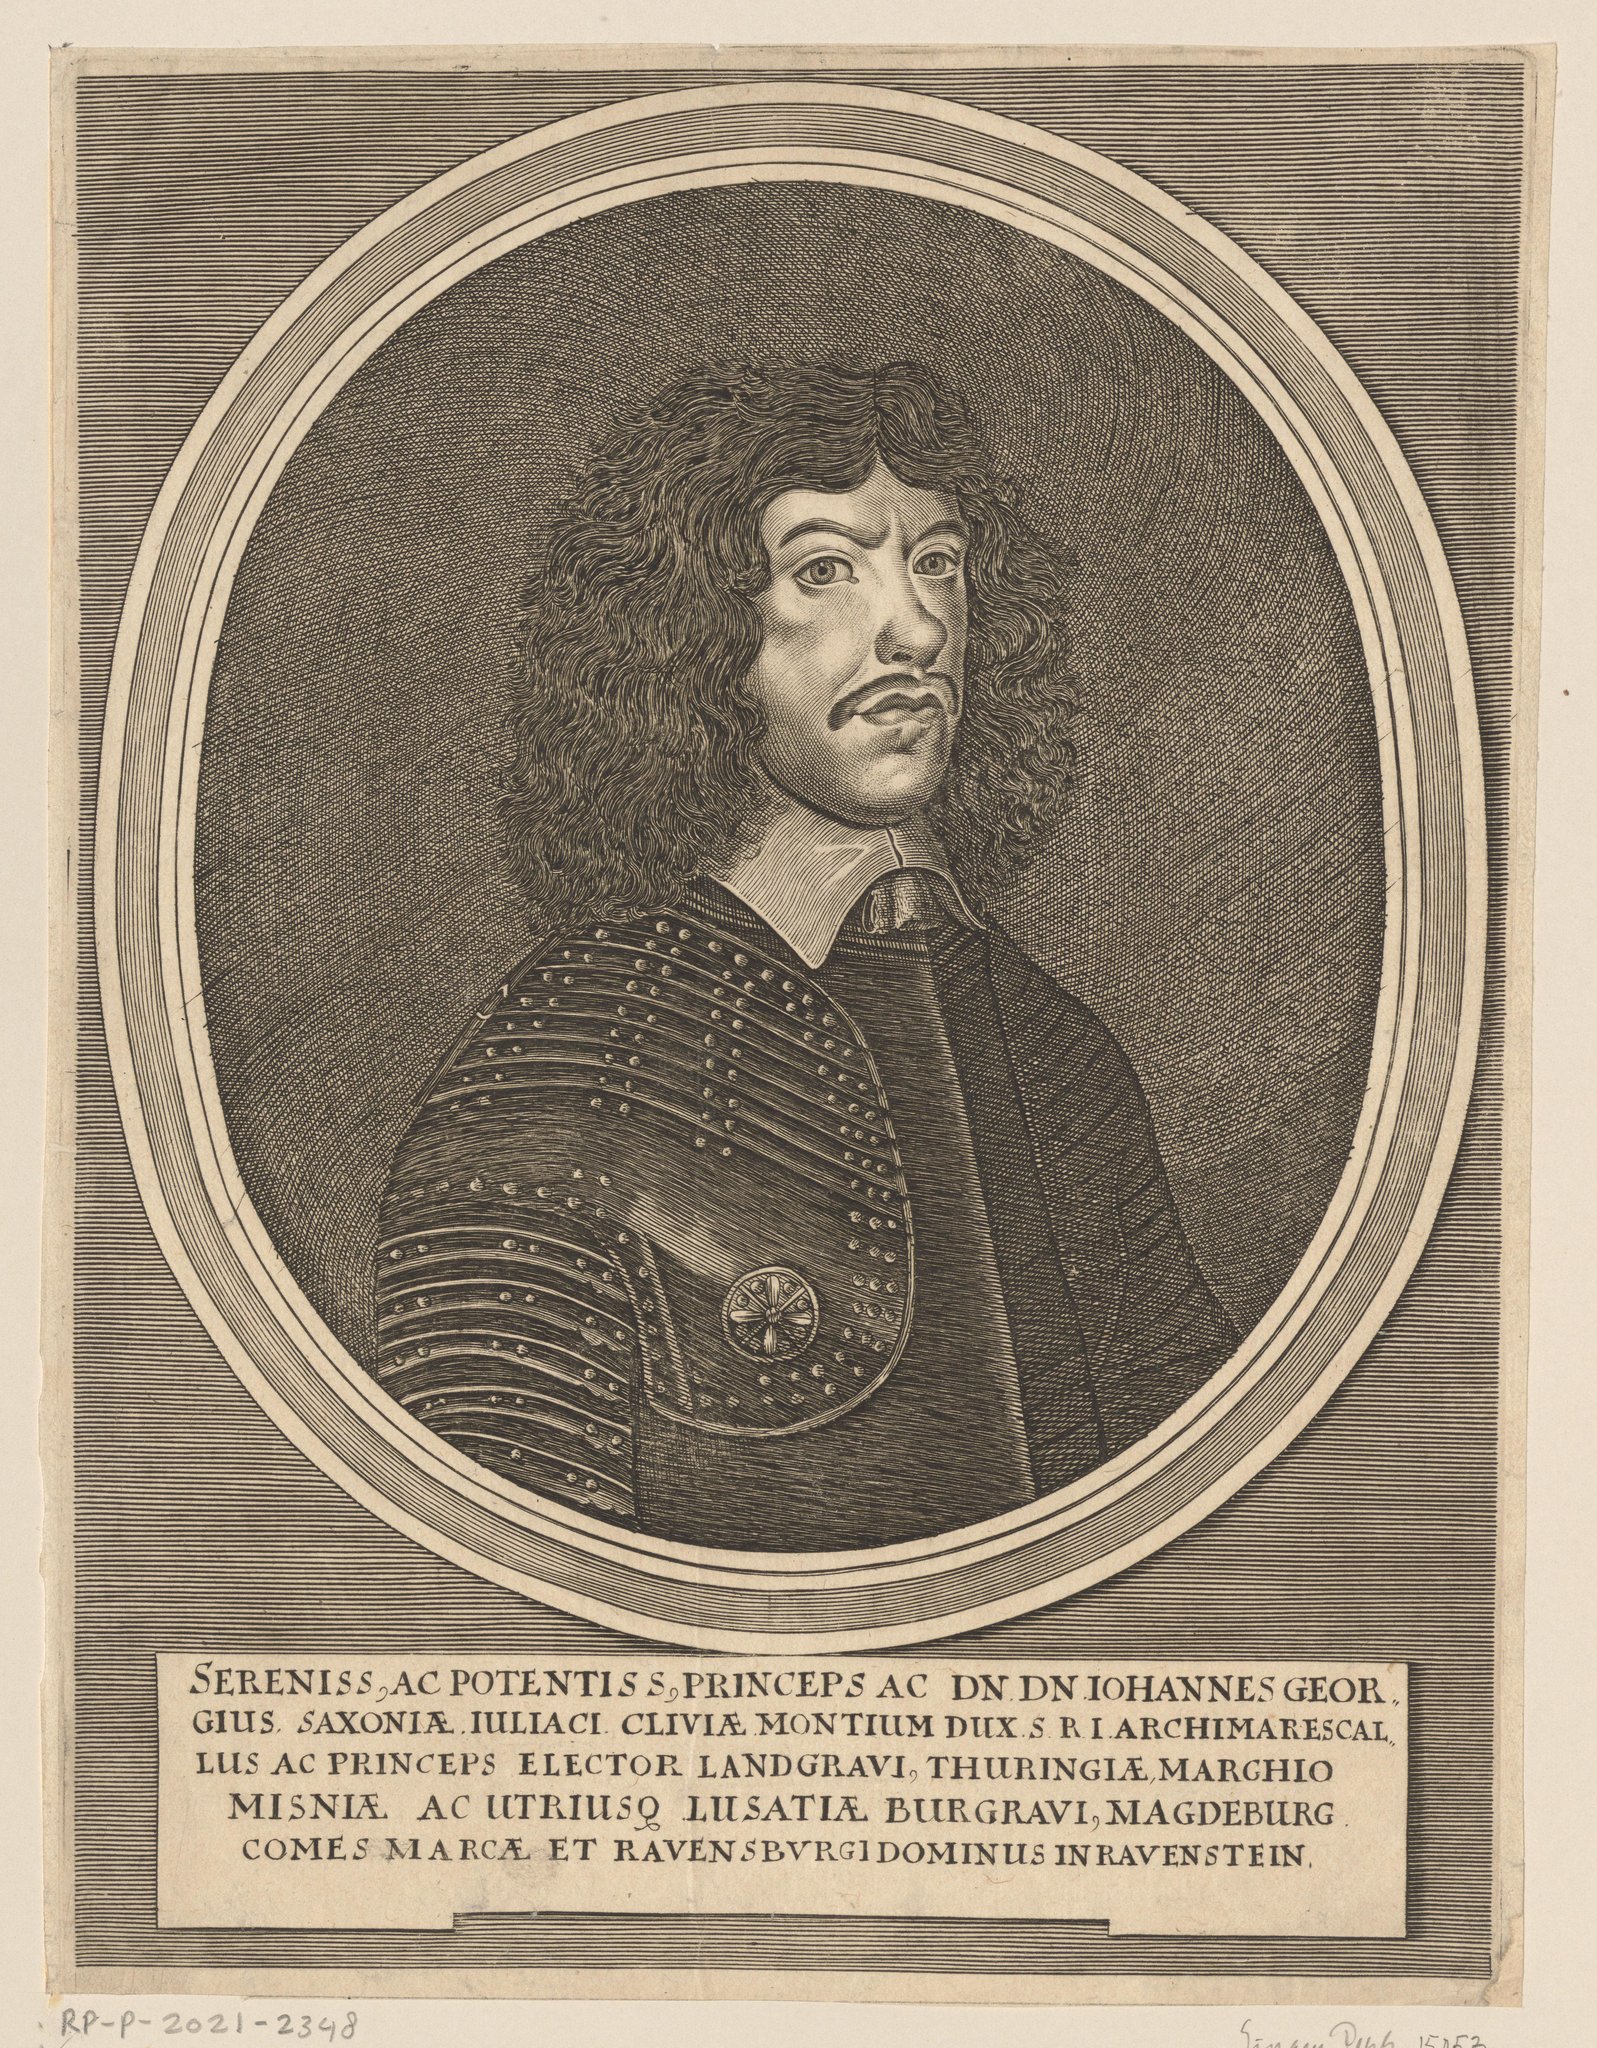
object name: print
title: Portret van Johan George II van Saksen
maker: Anonymous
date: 1656-1749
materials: paper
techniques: engraving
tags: historical persons, ruler, sovereign